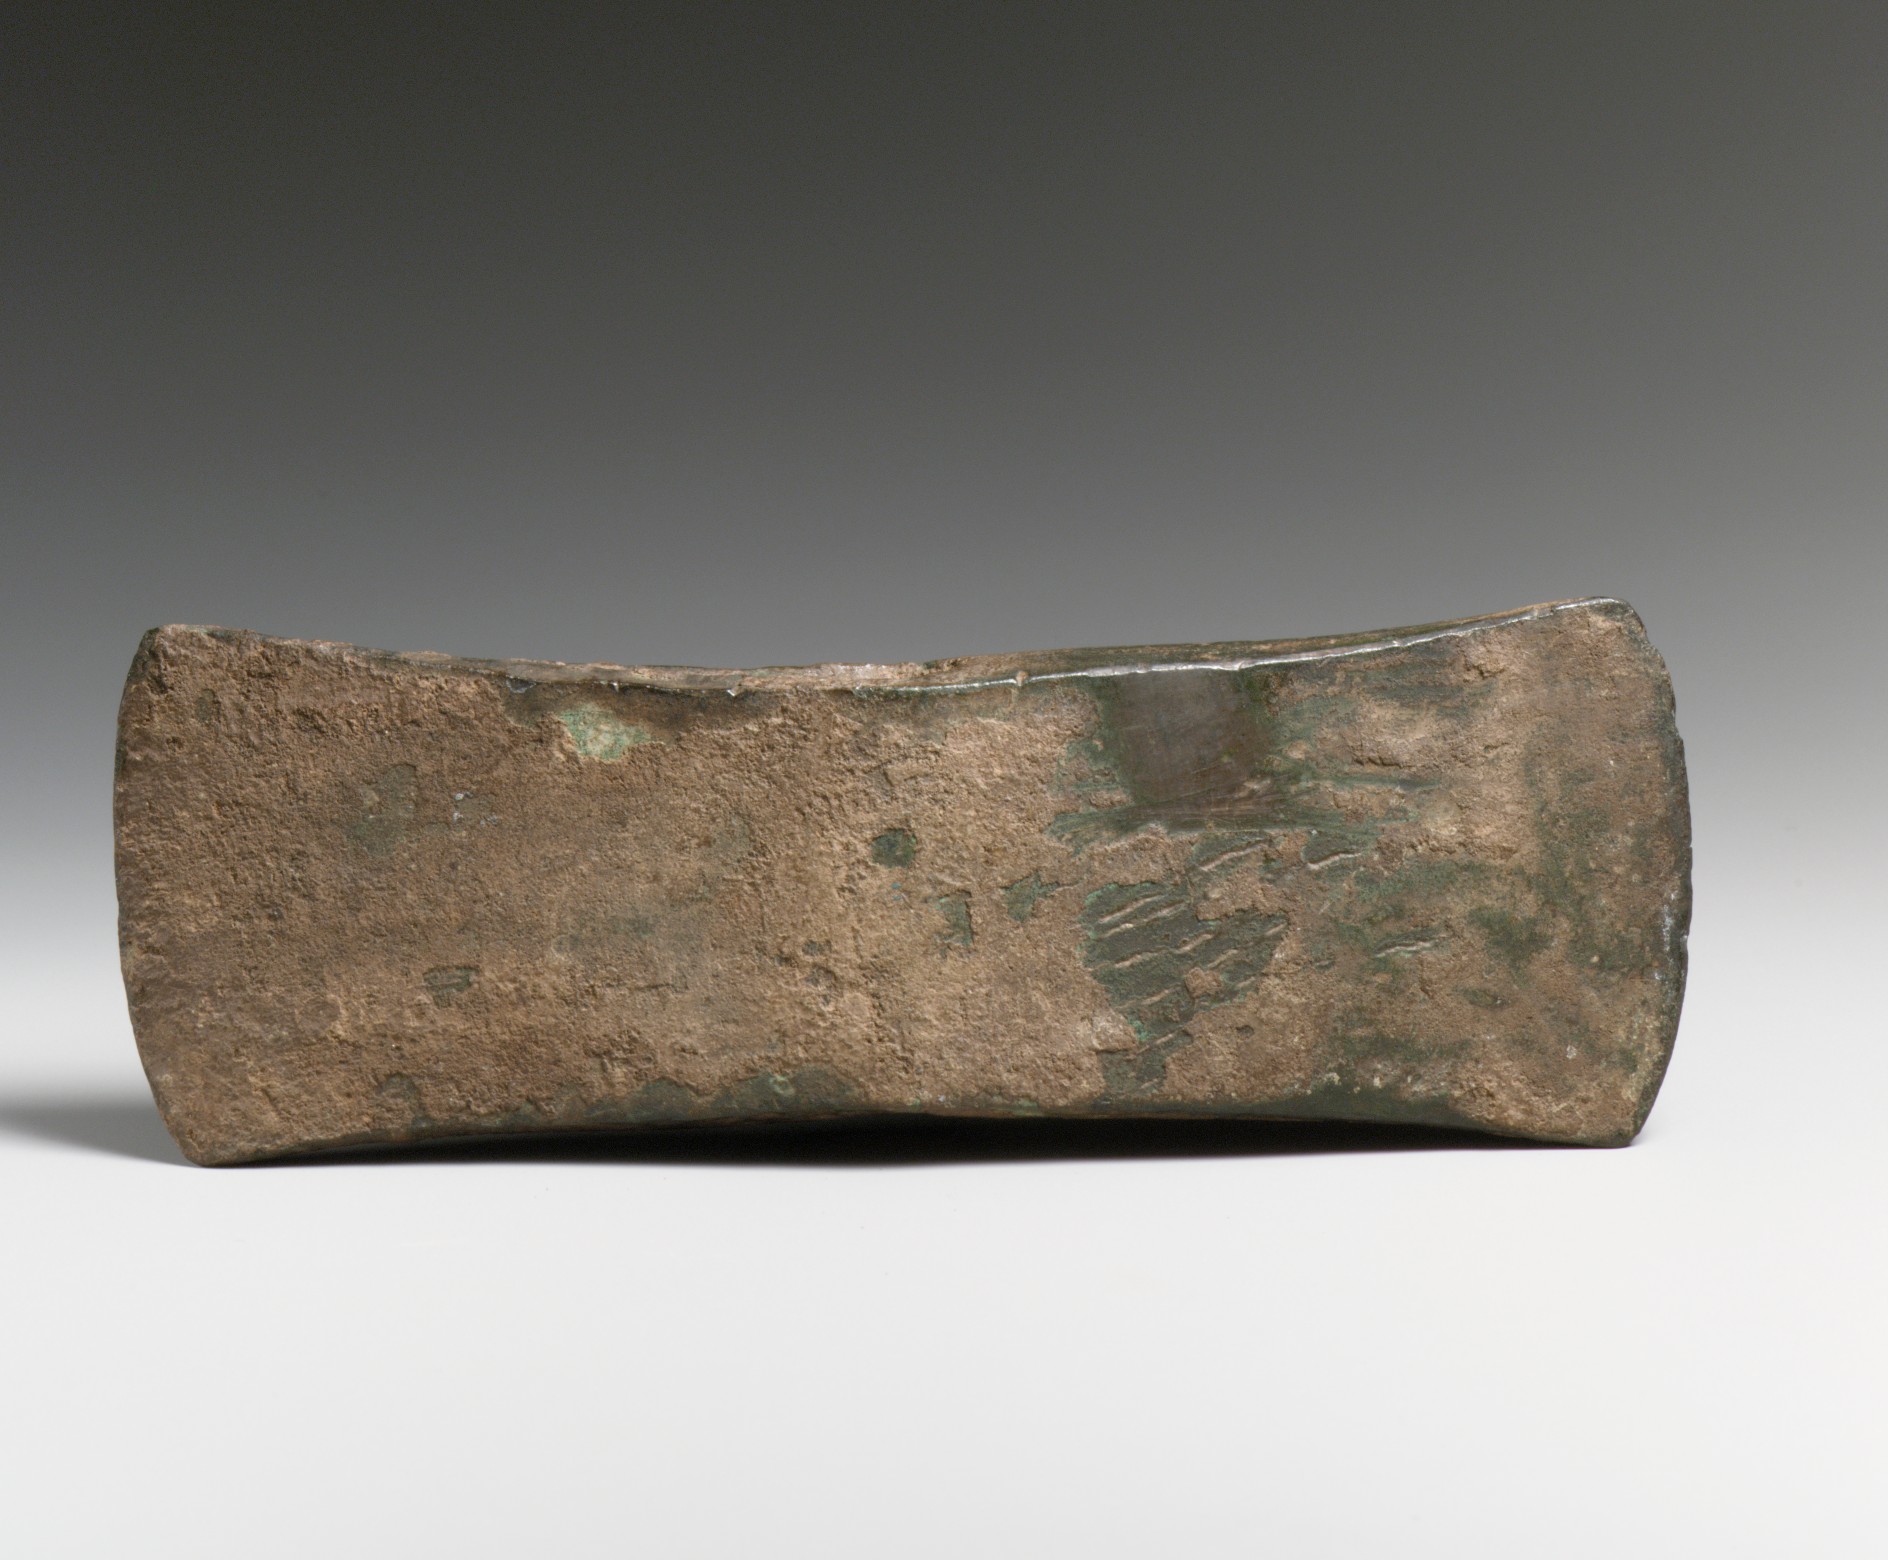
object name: axehead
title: Bronze double axe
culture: minoan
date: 1600-1050 BCE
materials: bronze